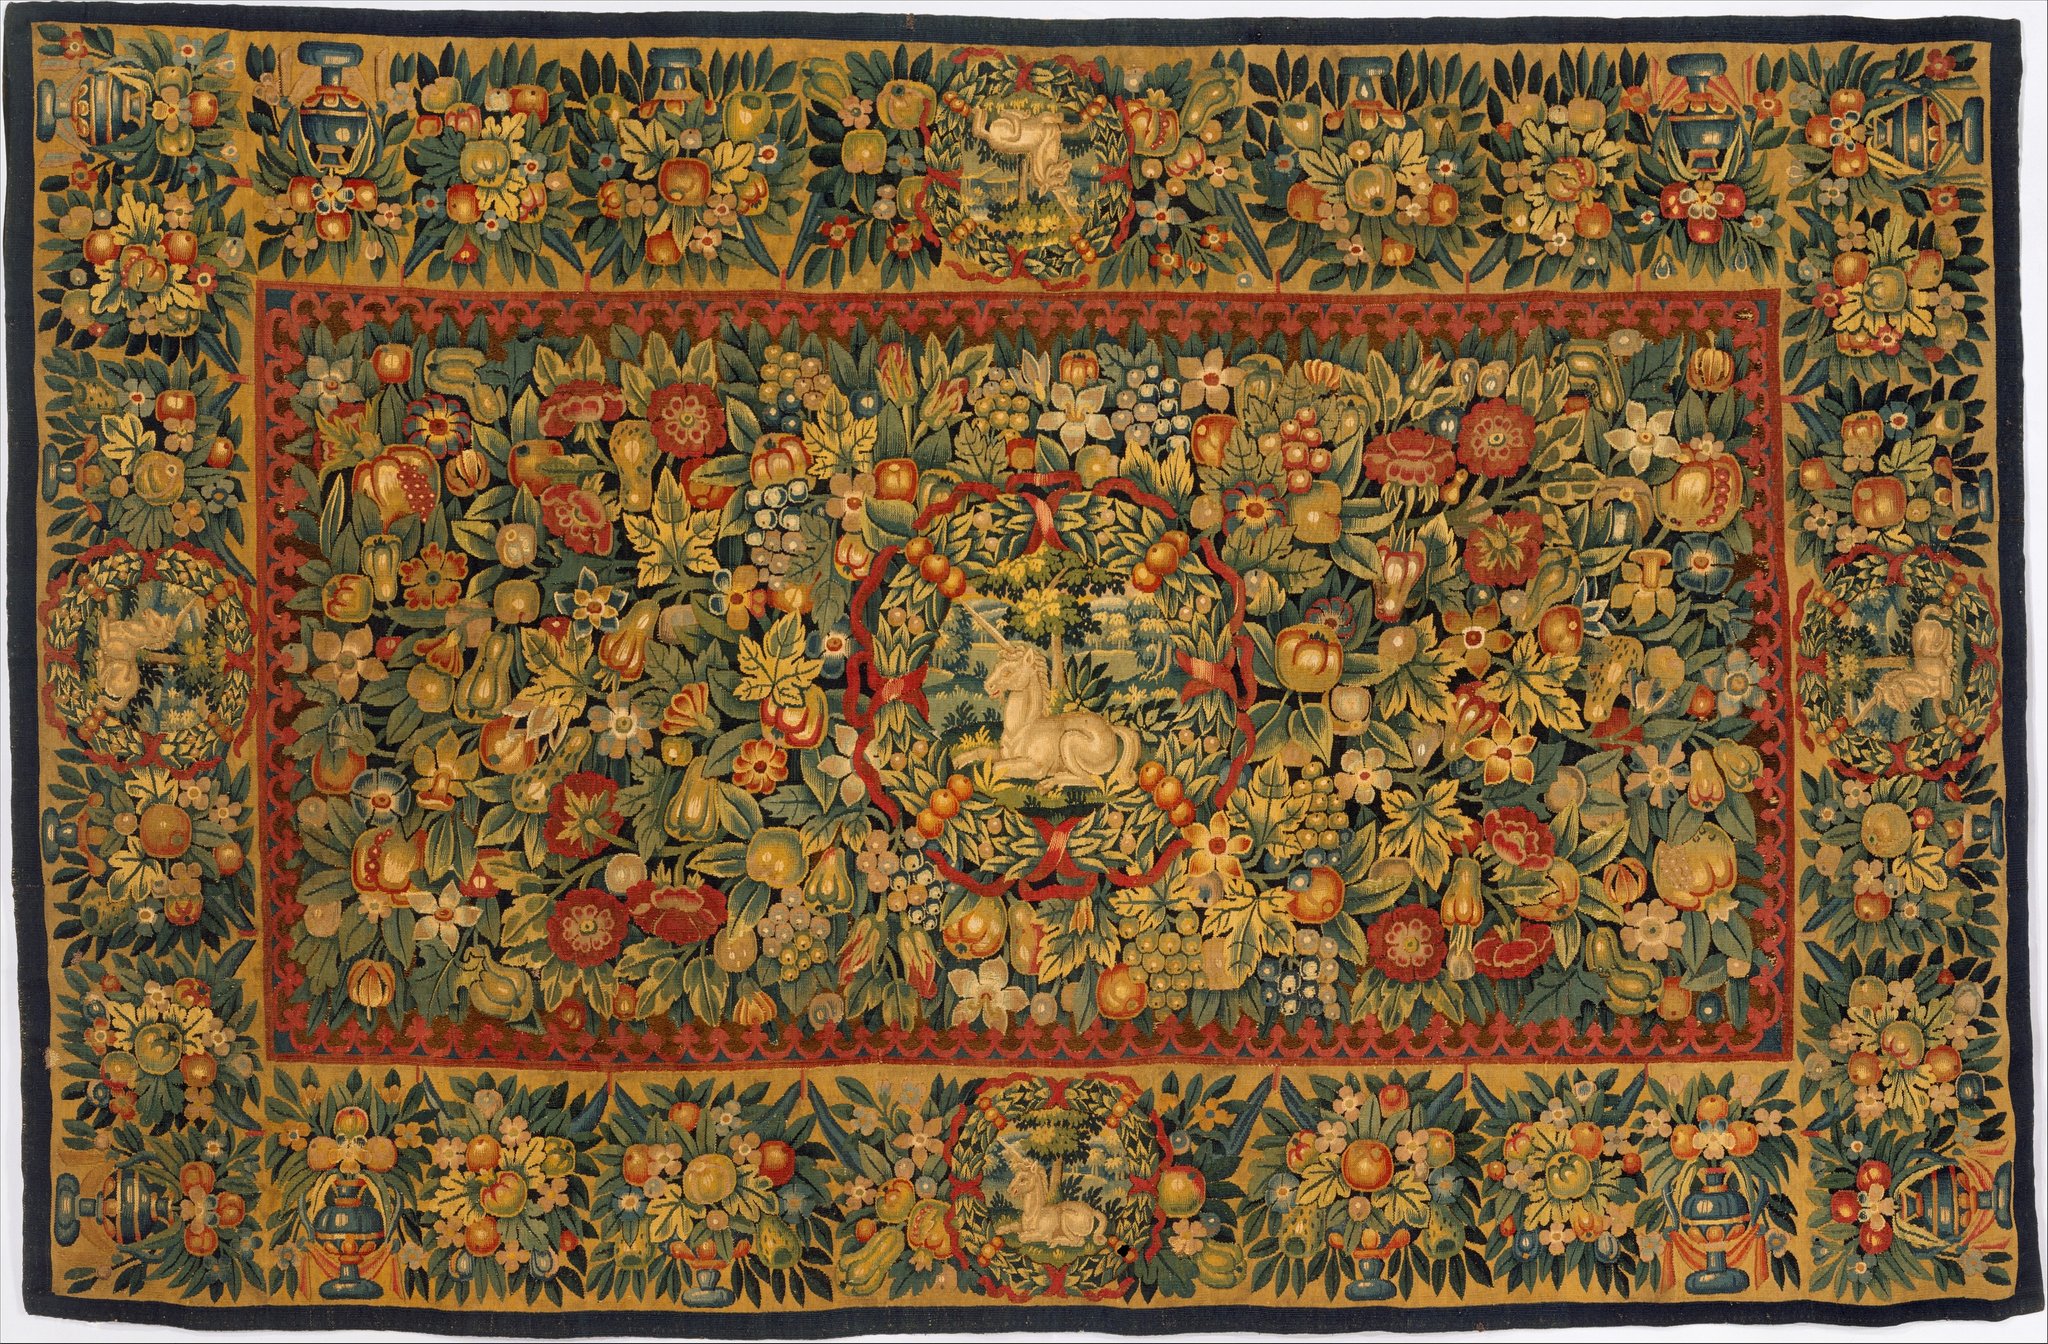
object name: table carpet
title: Table carpet with unicorns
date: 1600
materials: silk, wool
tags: fruit,unicorns,flowers